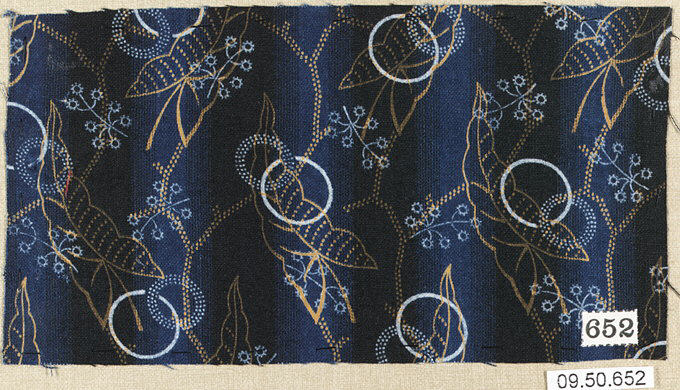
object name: piece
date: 1801-1900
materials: cotton